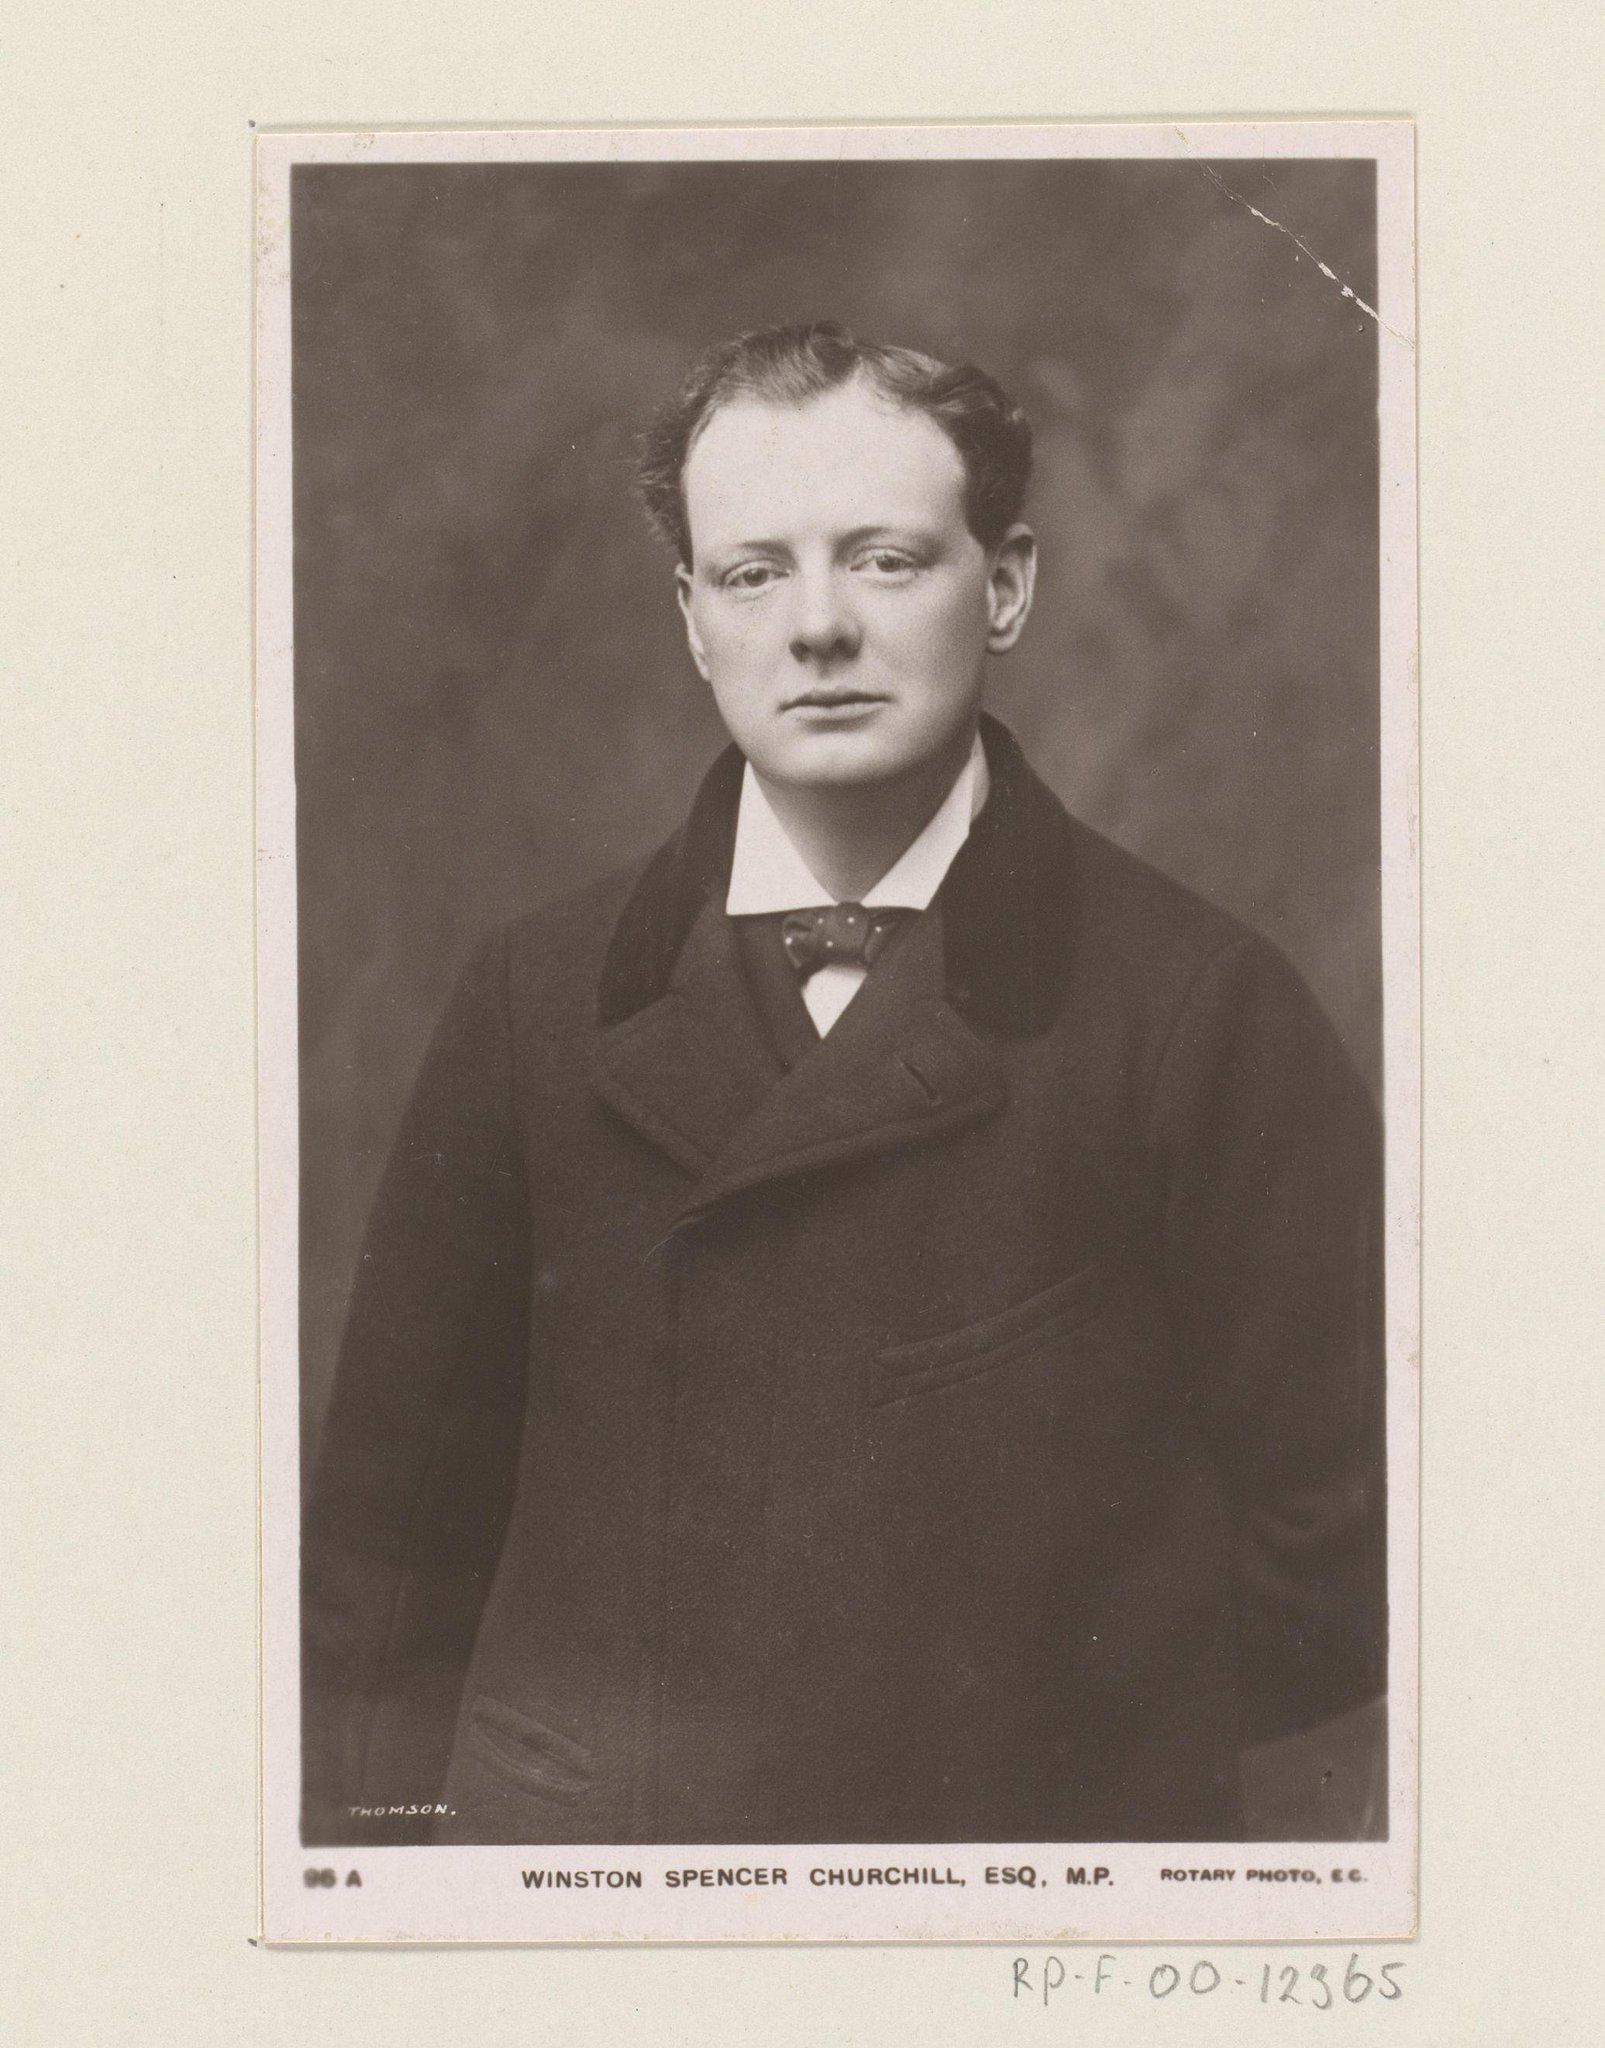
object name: ansichtkaart, prentbriefkaart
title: Winston Spencer Churchill, Esq. M.P.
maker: john thomson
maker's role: fotograaf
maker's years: 1837-1921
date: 1901-1921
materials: paper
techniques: gelatin silver print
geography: london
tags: london, historical persons, politician, e.g. party leader